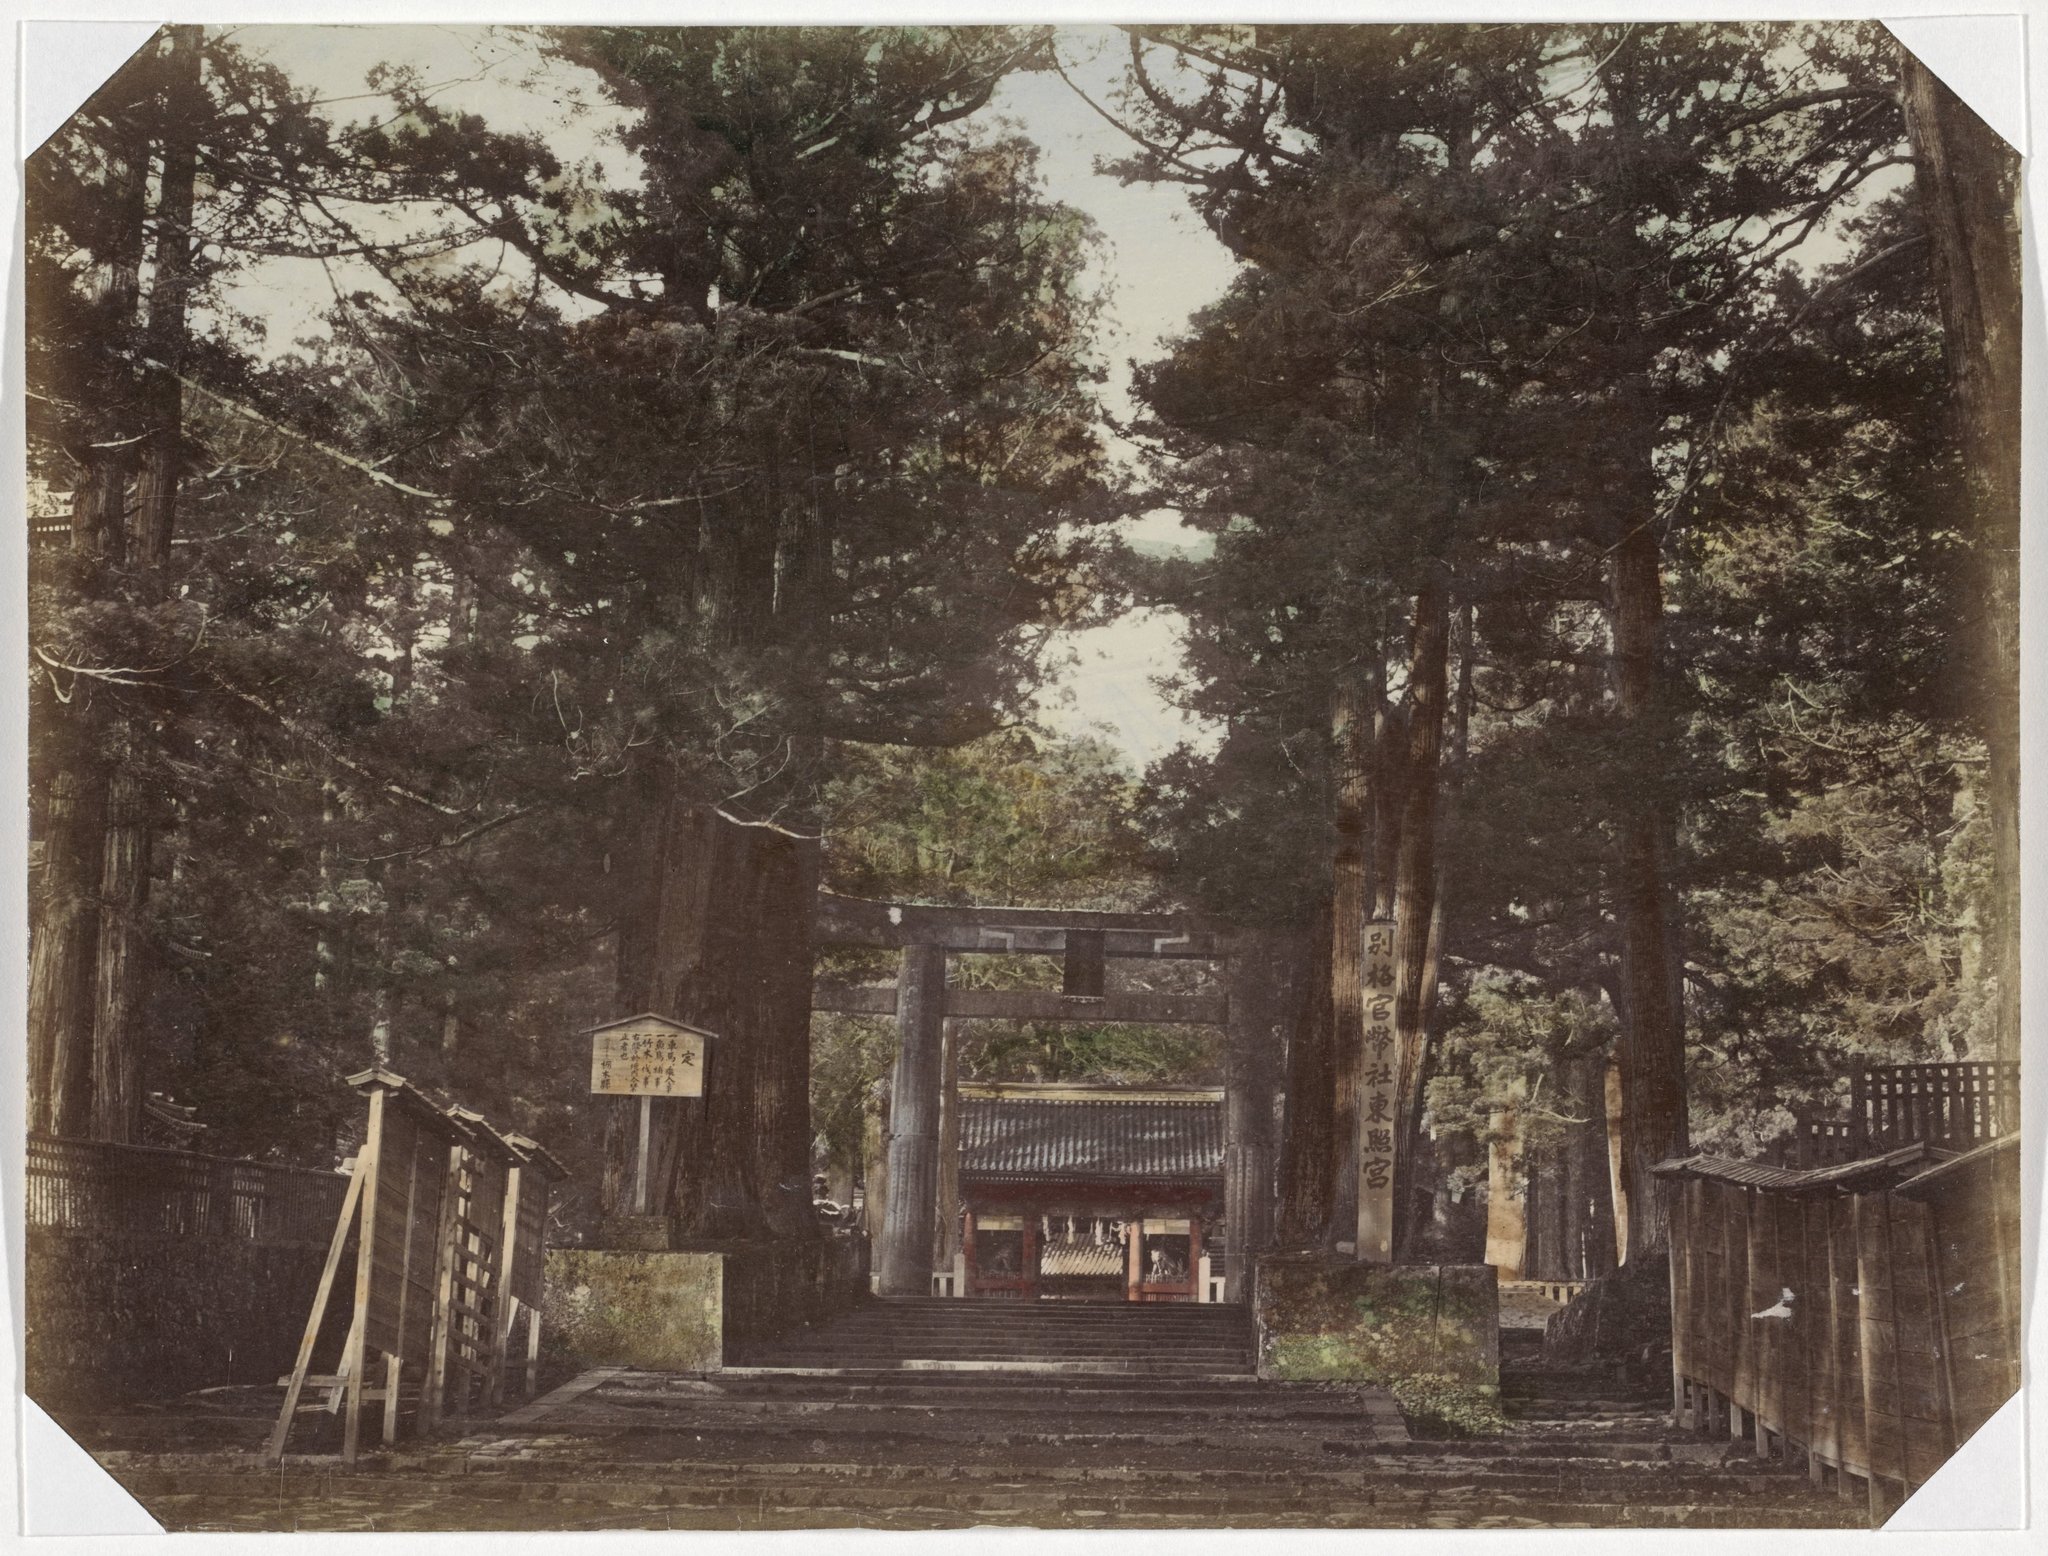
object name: photograph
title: Ingang van een tempel in Nikko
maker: Anonymous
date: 1890-1894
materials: cardboard, paper, photographic support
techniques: albumen print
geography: nikko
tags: temple, shrine ~ hinduism, buddhism, jainism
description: Onderdeel van Album met 69 foto's van een reis door Japan.